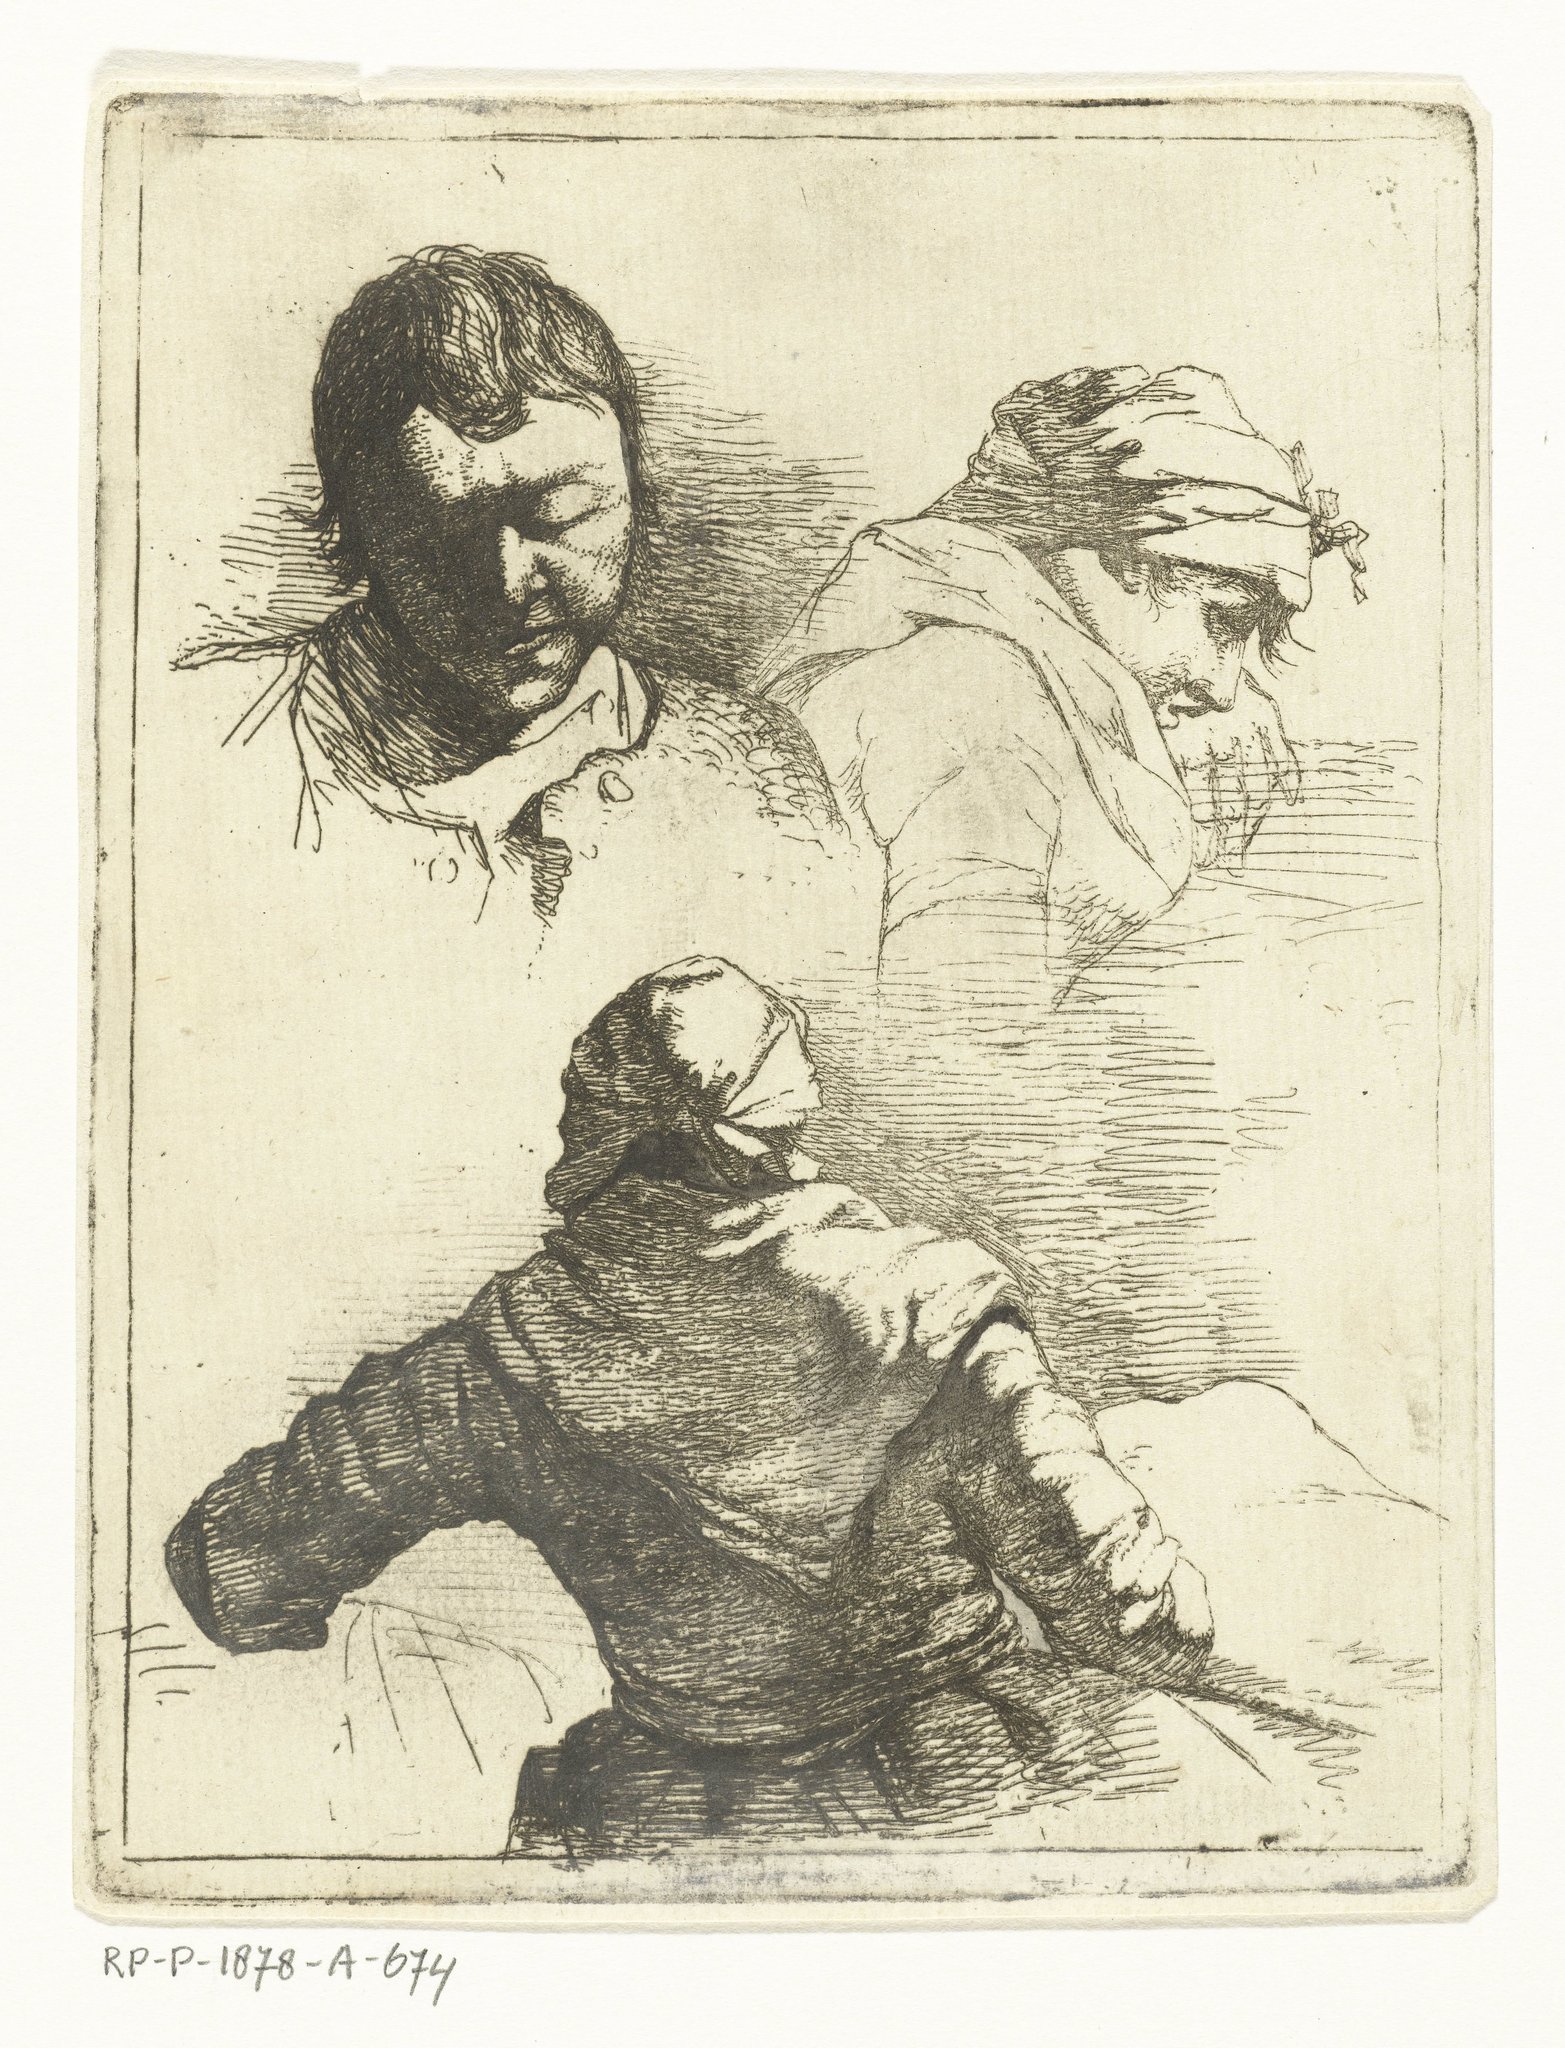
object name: print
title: Drie figuurstudies van vrouw en man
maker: albertus brondgeest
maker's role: draughtsman, print maker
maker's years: 1786-1849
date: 1796-1849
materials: paper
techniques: etching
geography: netherlands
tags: postures of the head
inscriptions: collector's mark: Lugt 2228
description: Figuurstudie van zittende vrouw met hoofddoek op de rug gezien en hoofden van dezelfde vrouw van opzij en man van voren gezien.